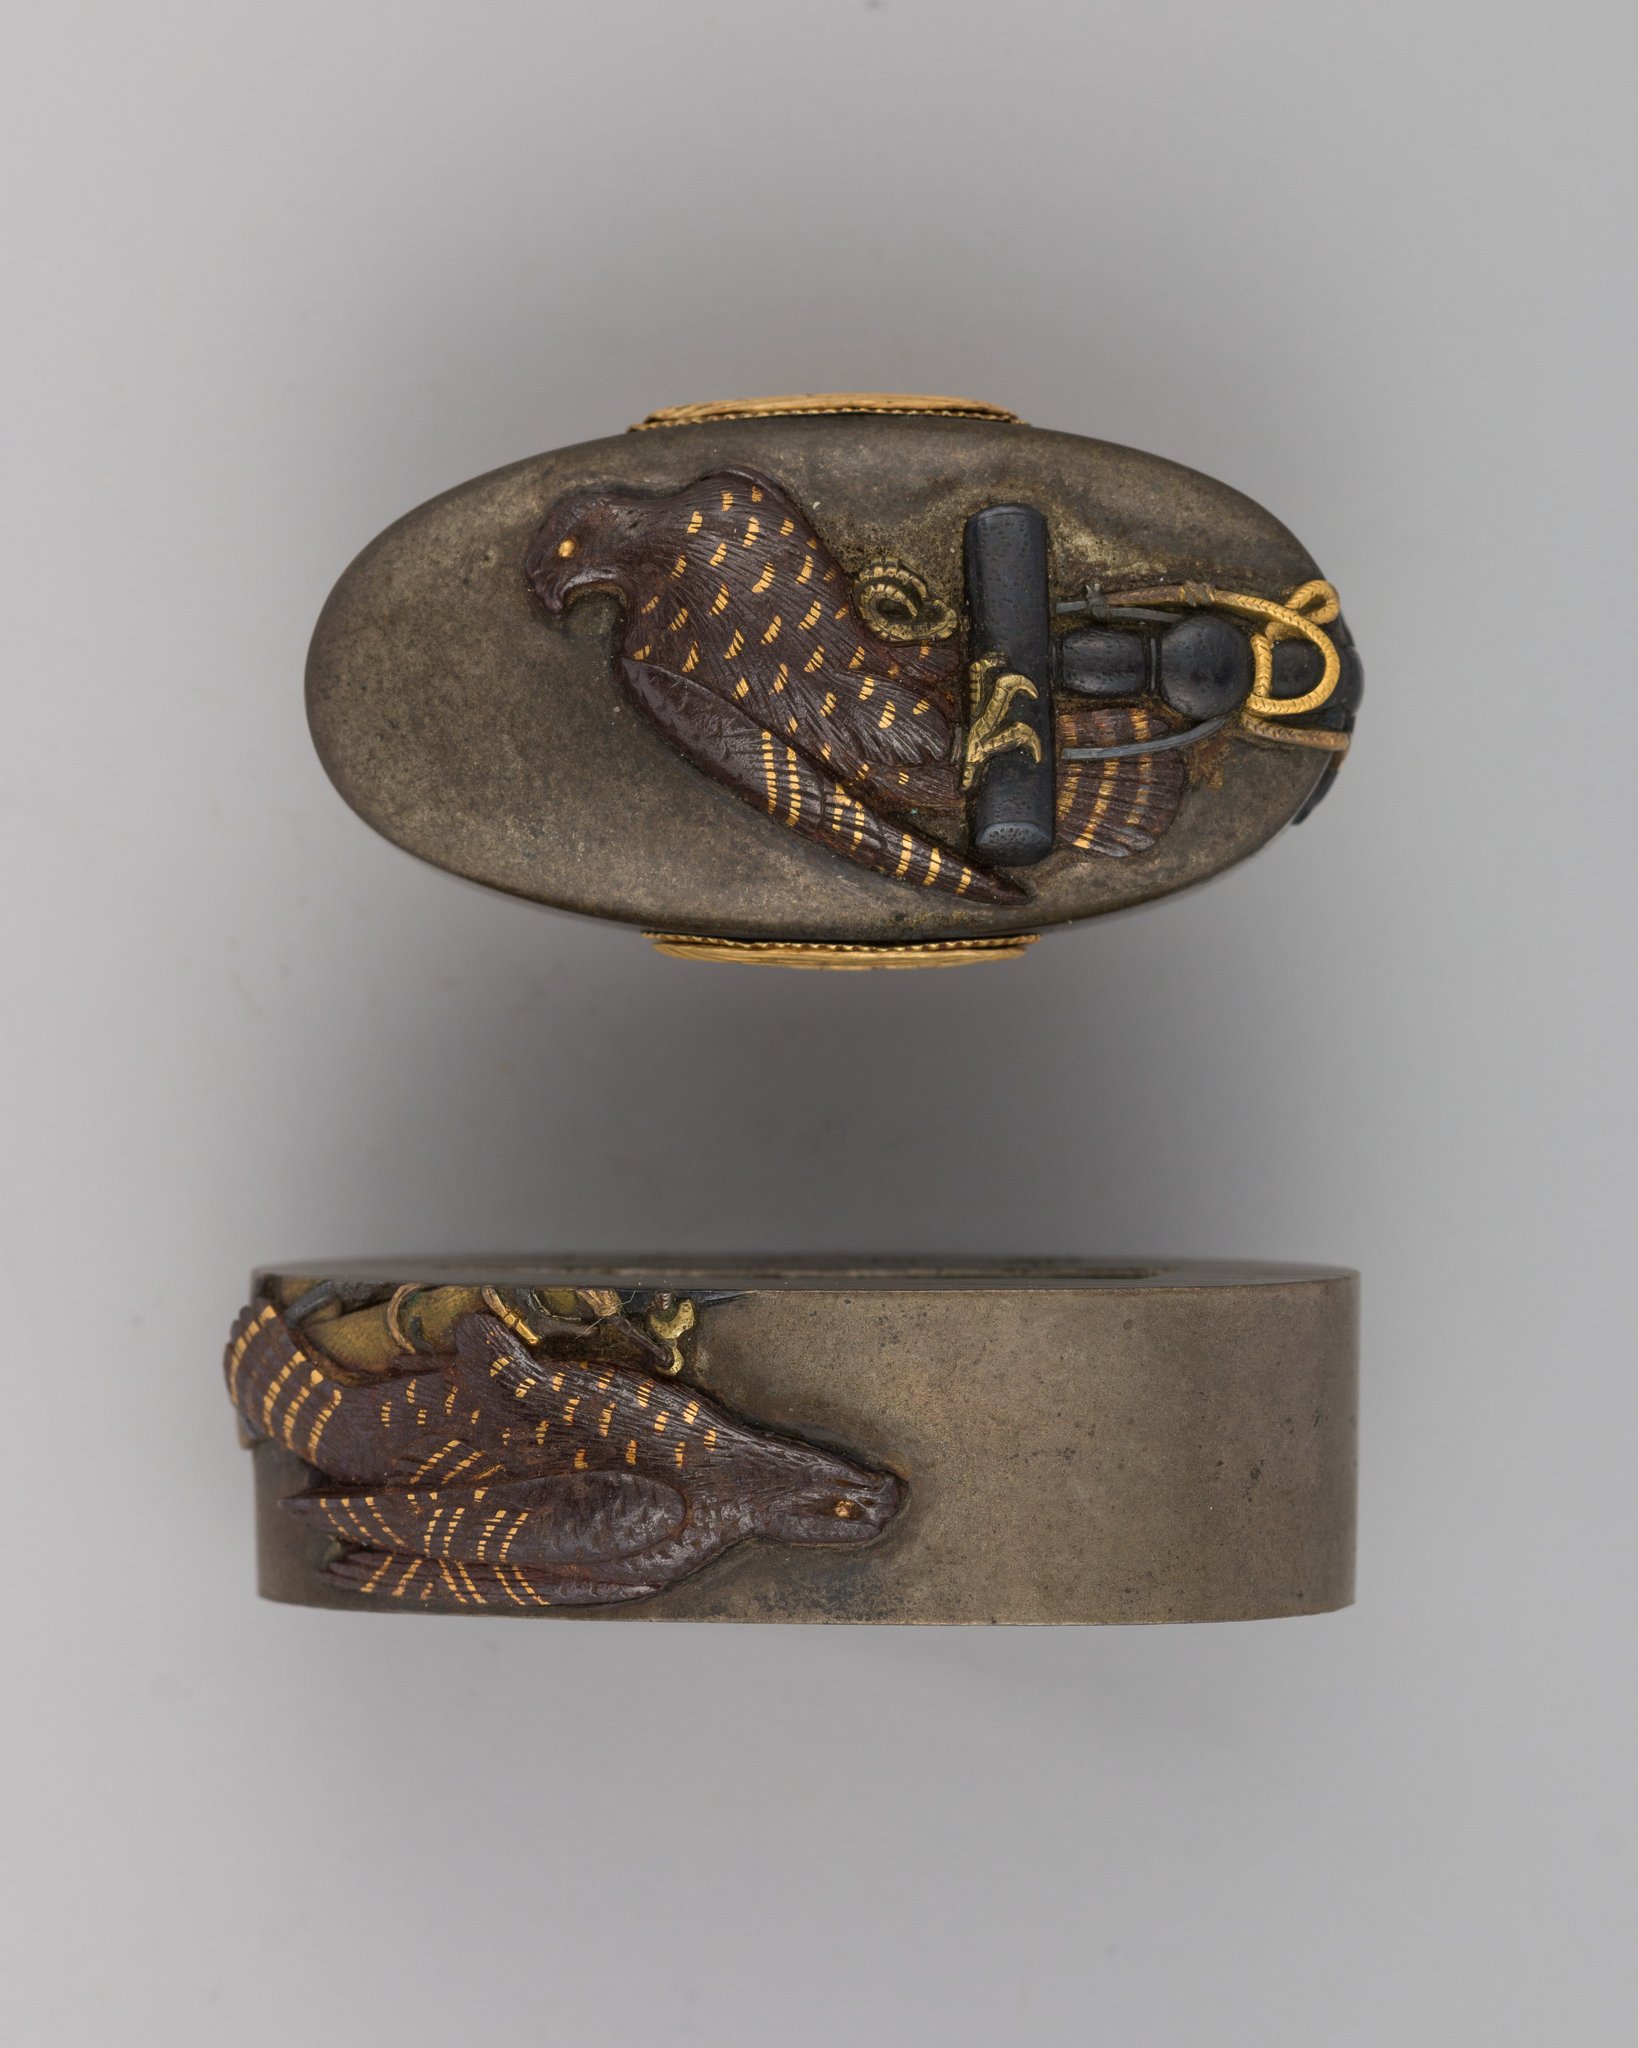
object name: sword hilt collar and pommel fuchigashira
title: Sword-Hilt Collar and Pommel (Fuchigashira)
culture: japanese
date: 1801-1900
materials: silver alloy, gold, iron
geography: japan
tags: birds